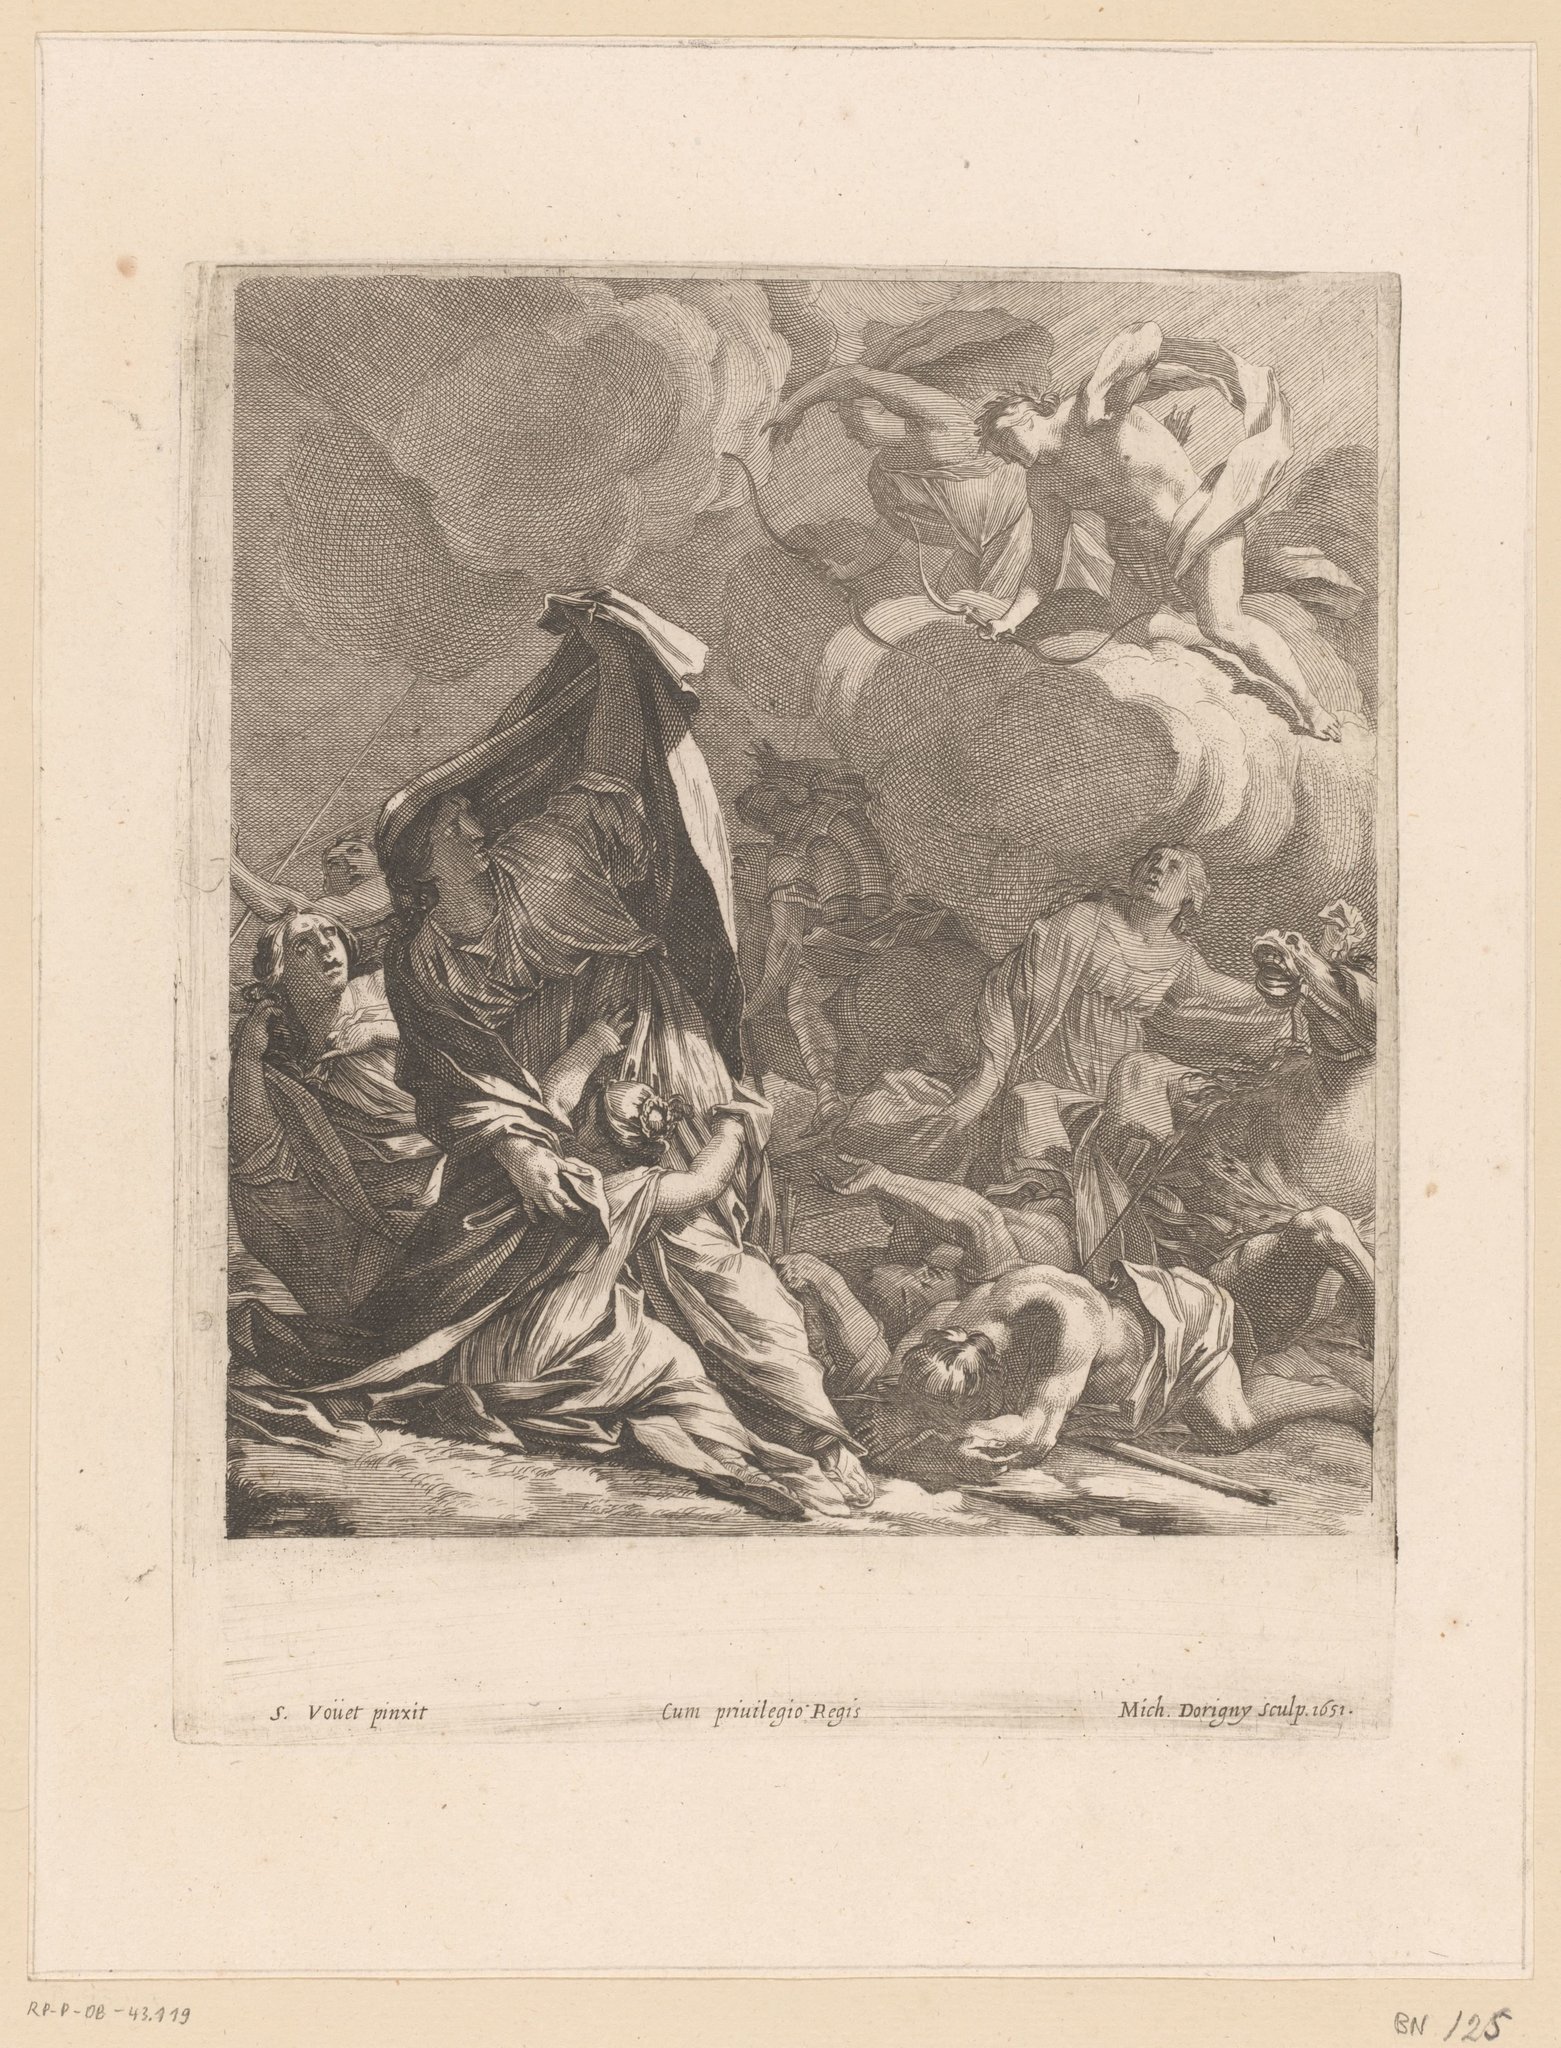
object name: print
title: Dood van Niobes kinderen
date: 1651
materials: paper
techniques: engraving, etching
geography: france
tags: apollo and diana kill niobe's children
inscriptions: collector's mark: Lugt 240